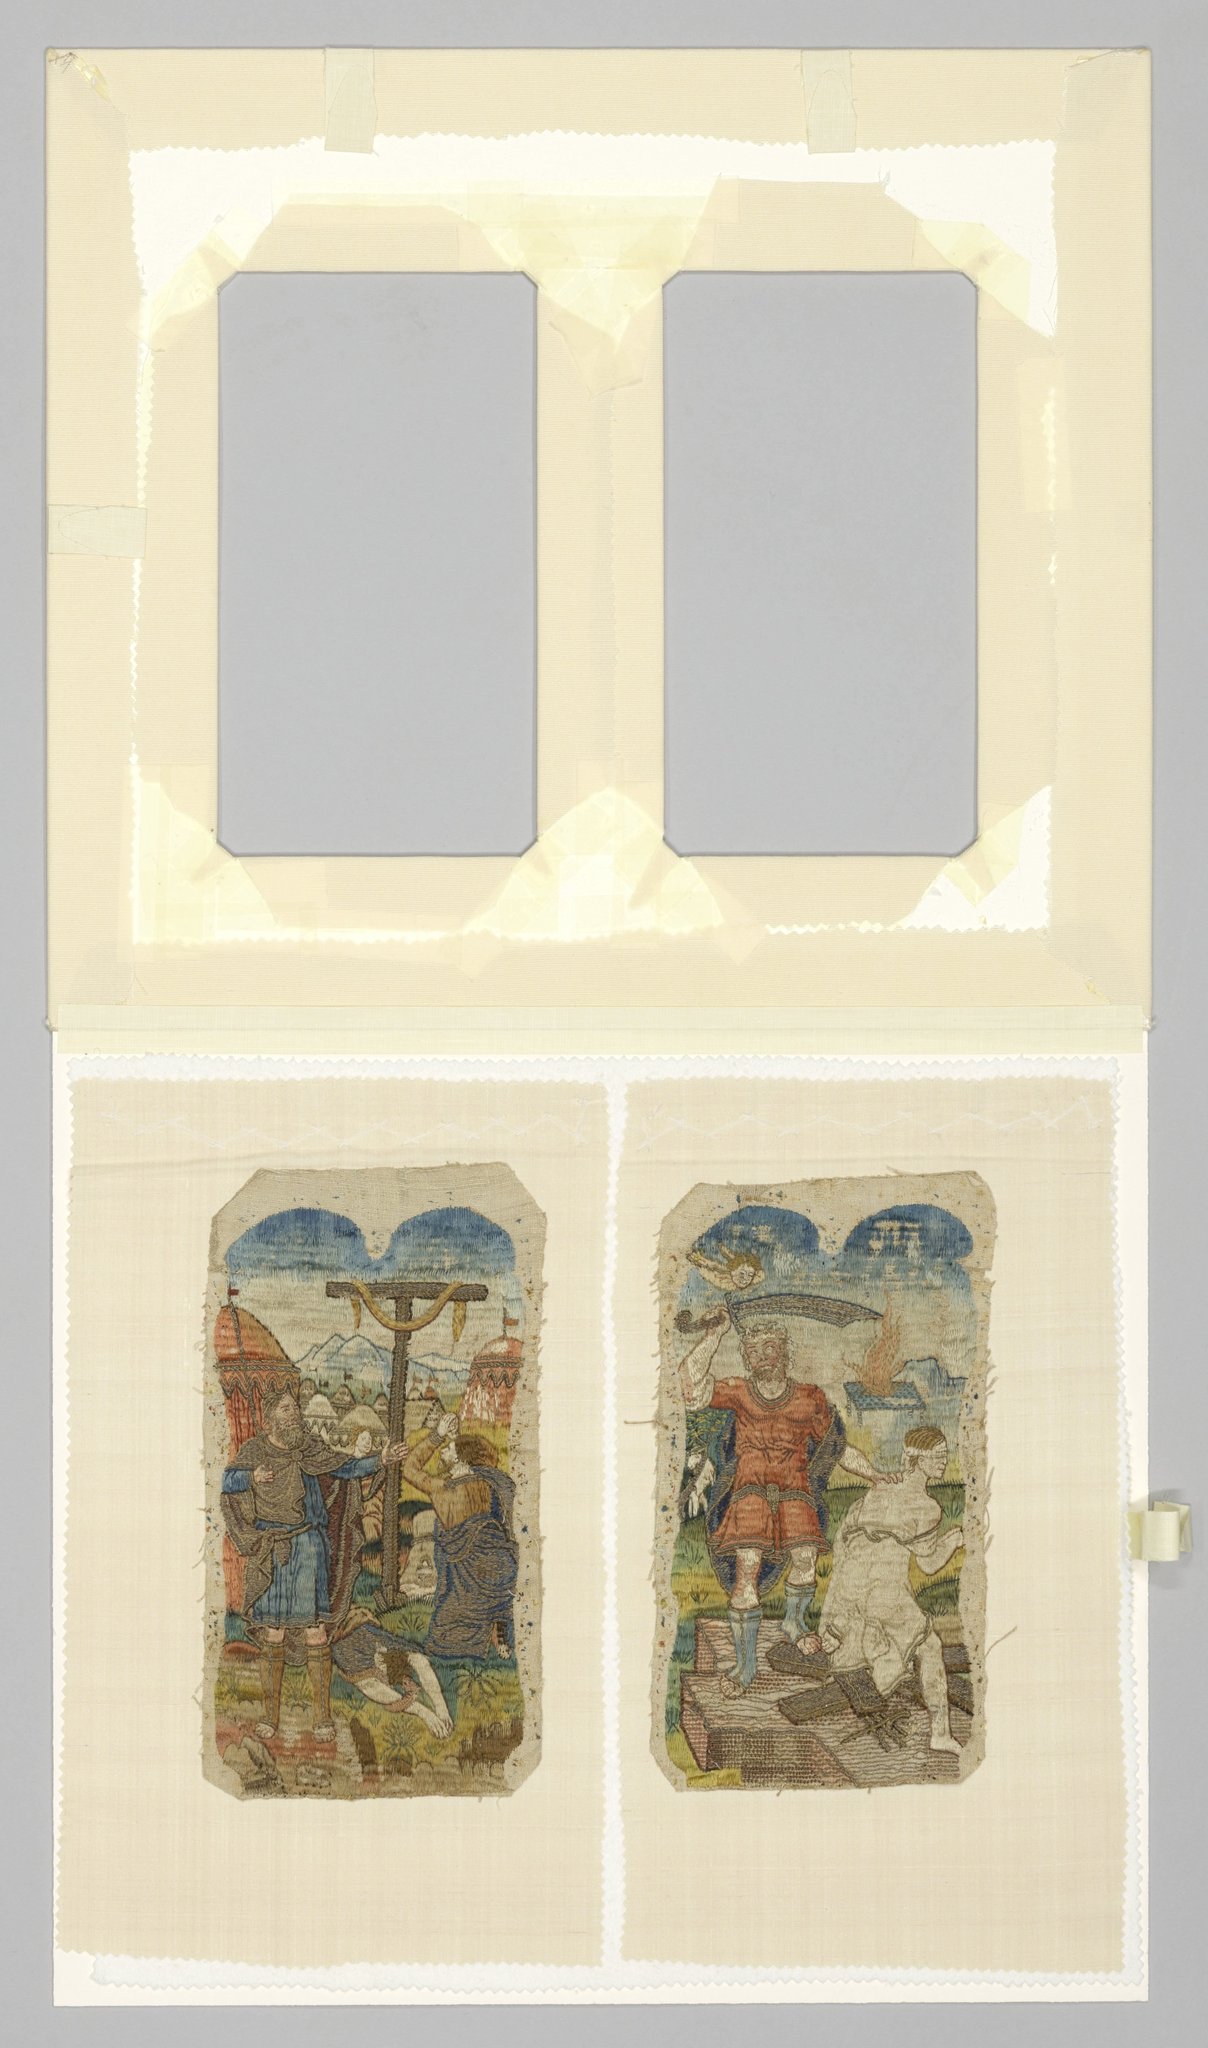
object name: aurifries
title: Aurifries met borduurwerk van zijde en gouddraad op linnen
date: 1525-1530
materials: gold thread, linen, silk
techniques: embroidered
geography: southern netherlands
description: Aurifries met borduurwerk. Het borduurwerk heeft een afbeelding van Abraham's offer. Isaac knielt geblinddoekt op de brandstapel. Links staat Abraham met in zijn opgeheven arm een zwaard. Links is de ram in het braambos afgebeeld en linksboven de engel.